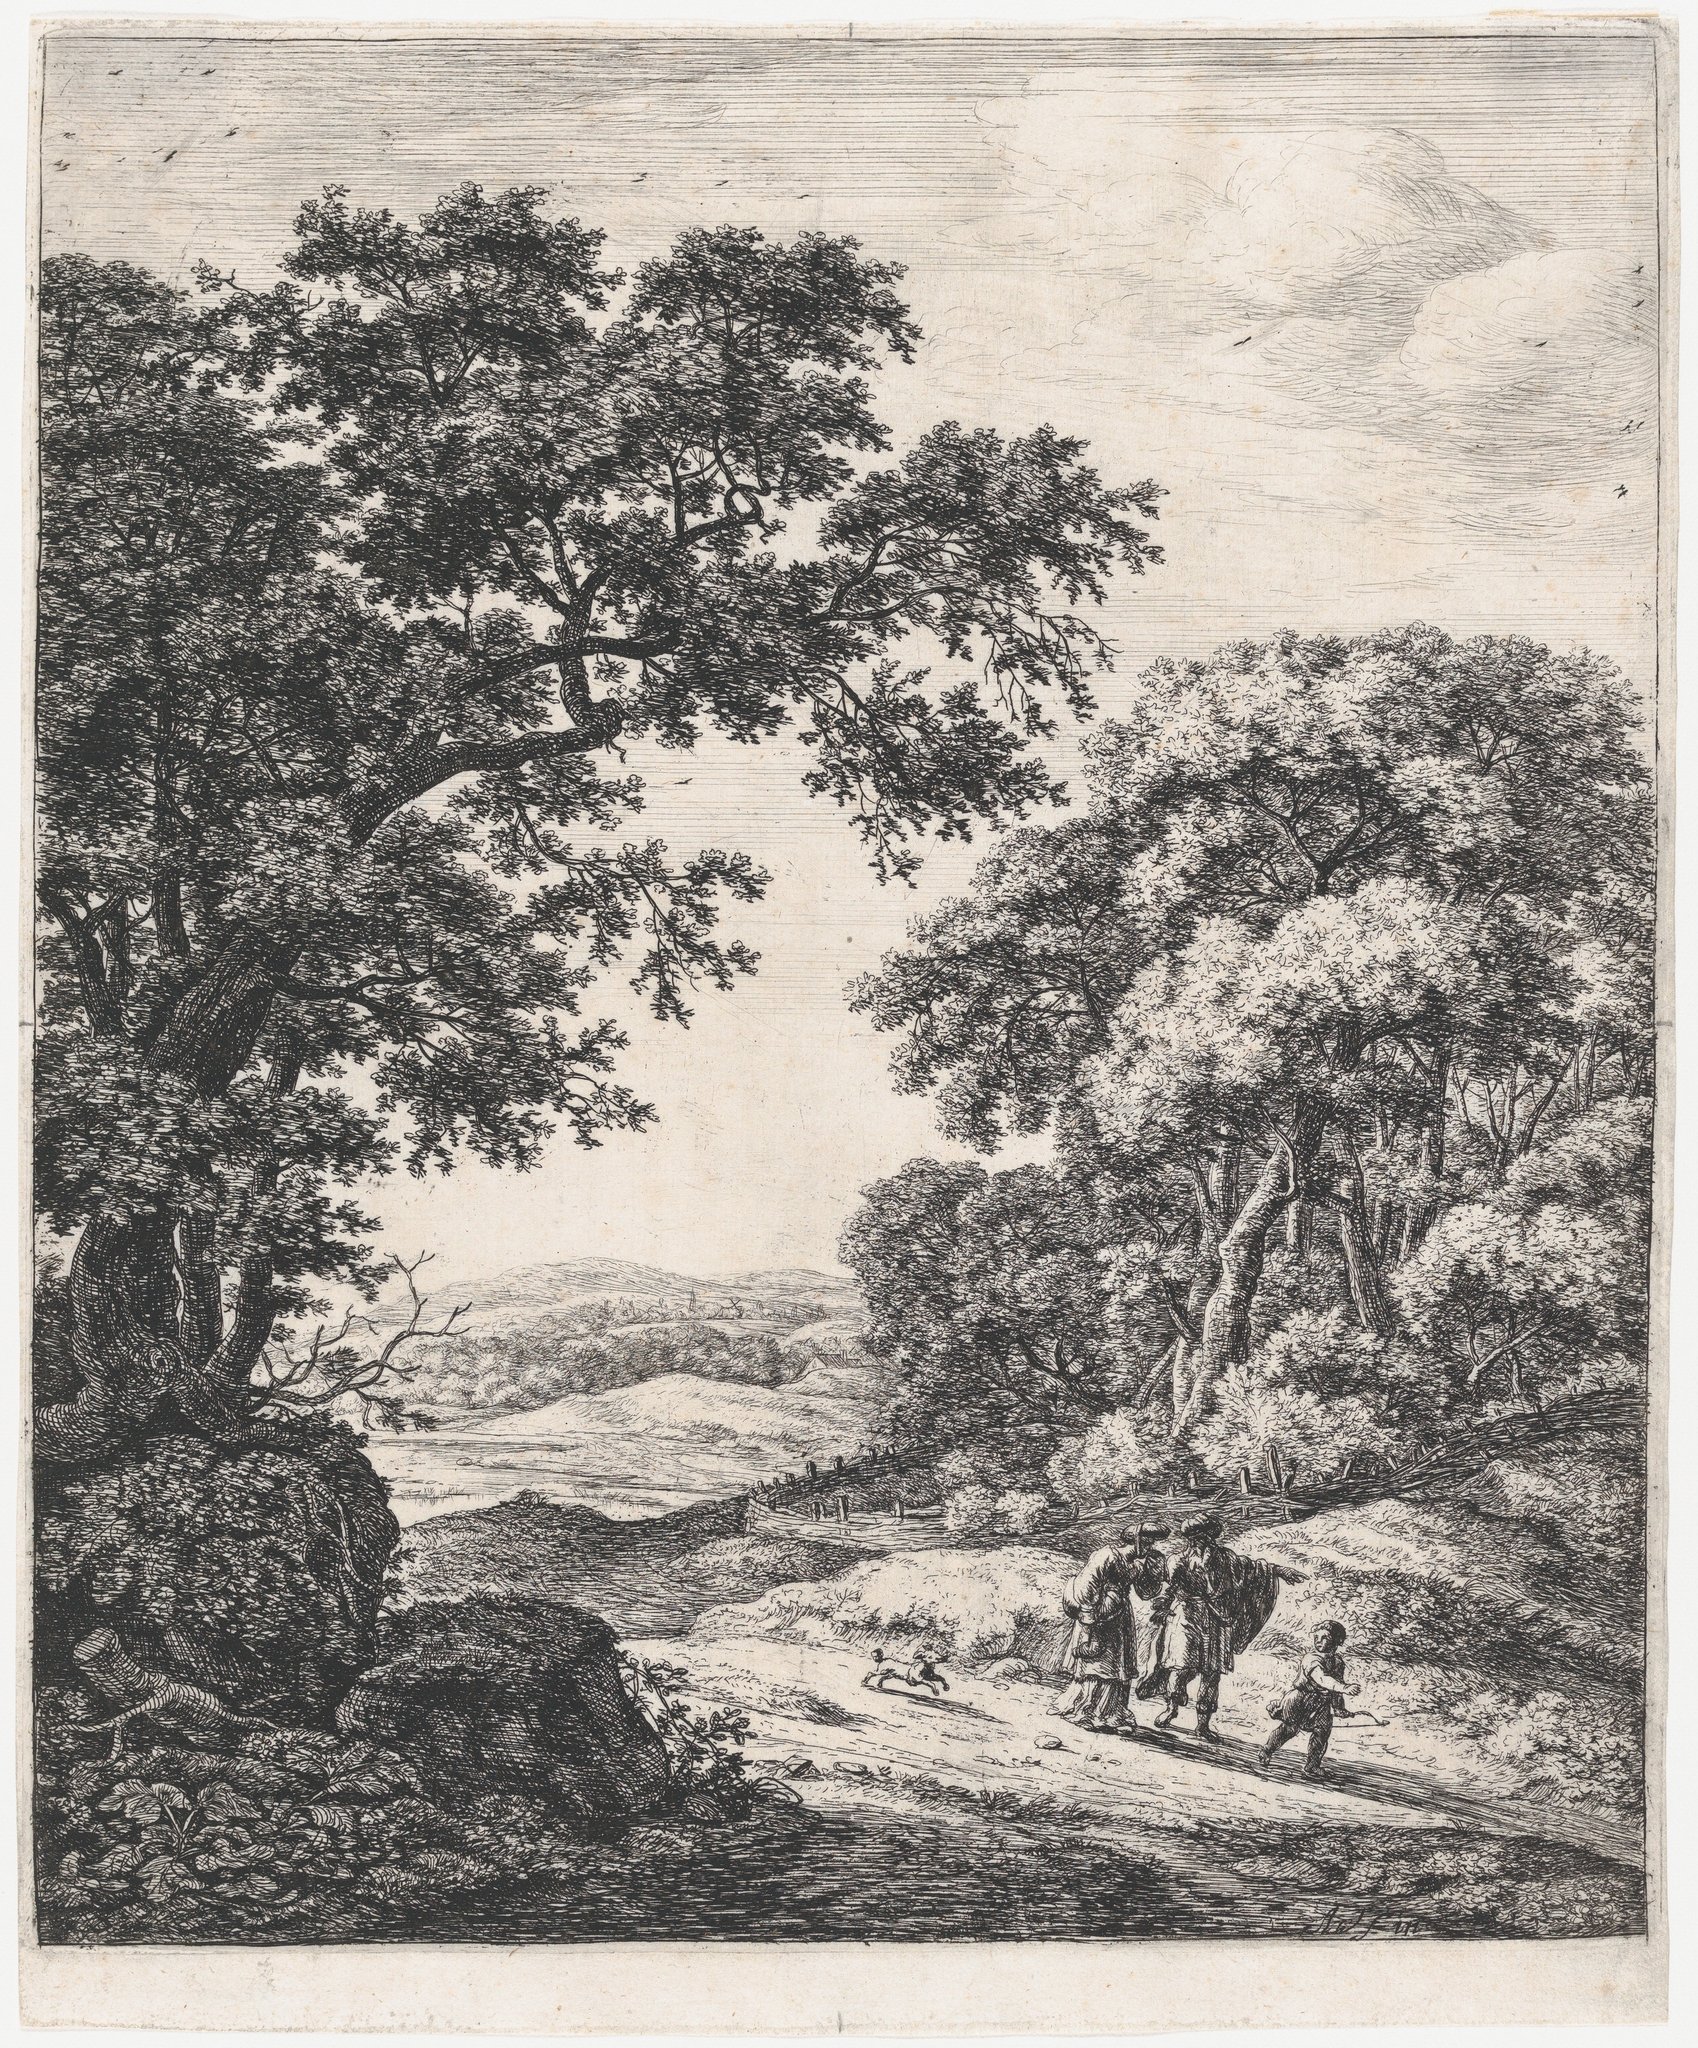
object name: print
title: The Departure of Hagar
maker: anthonie waterloo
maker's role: artist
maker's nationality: dutch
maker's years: 1609-1690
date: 1601-1700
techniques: etching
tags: human figures,landscapes,trees